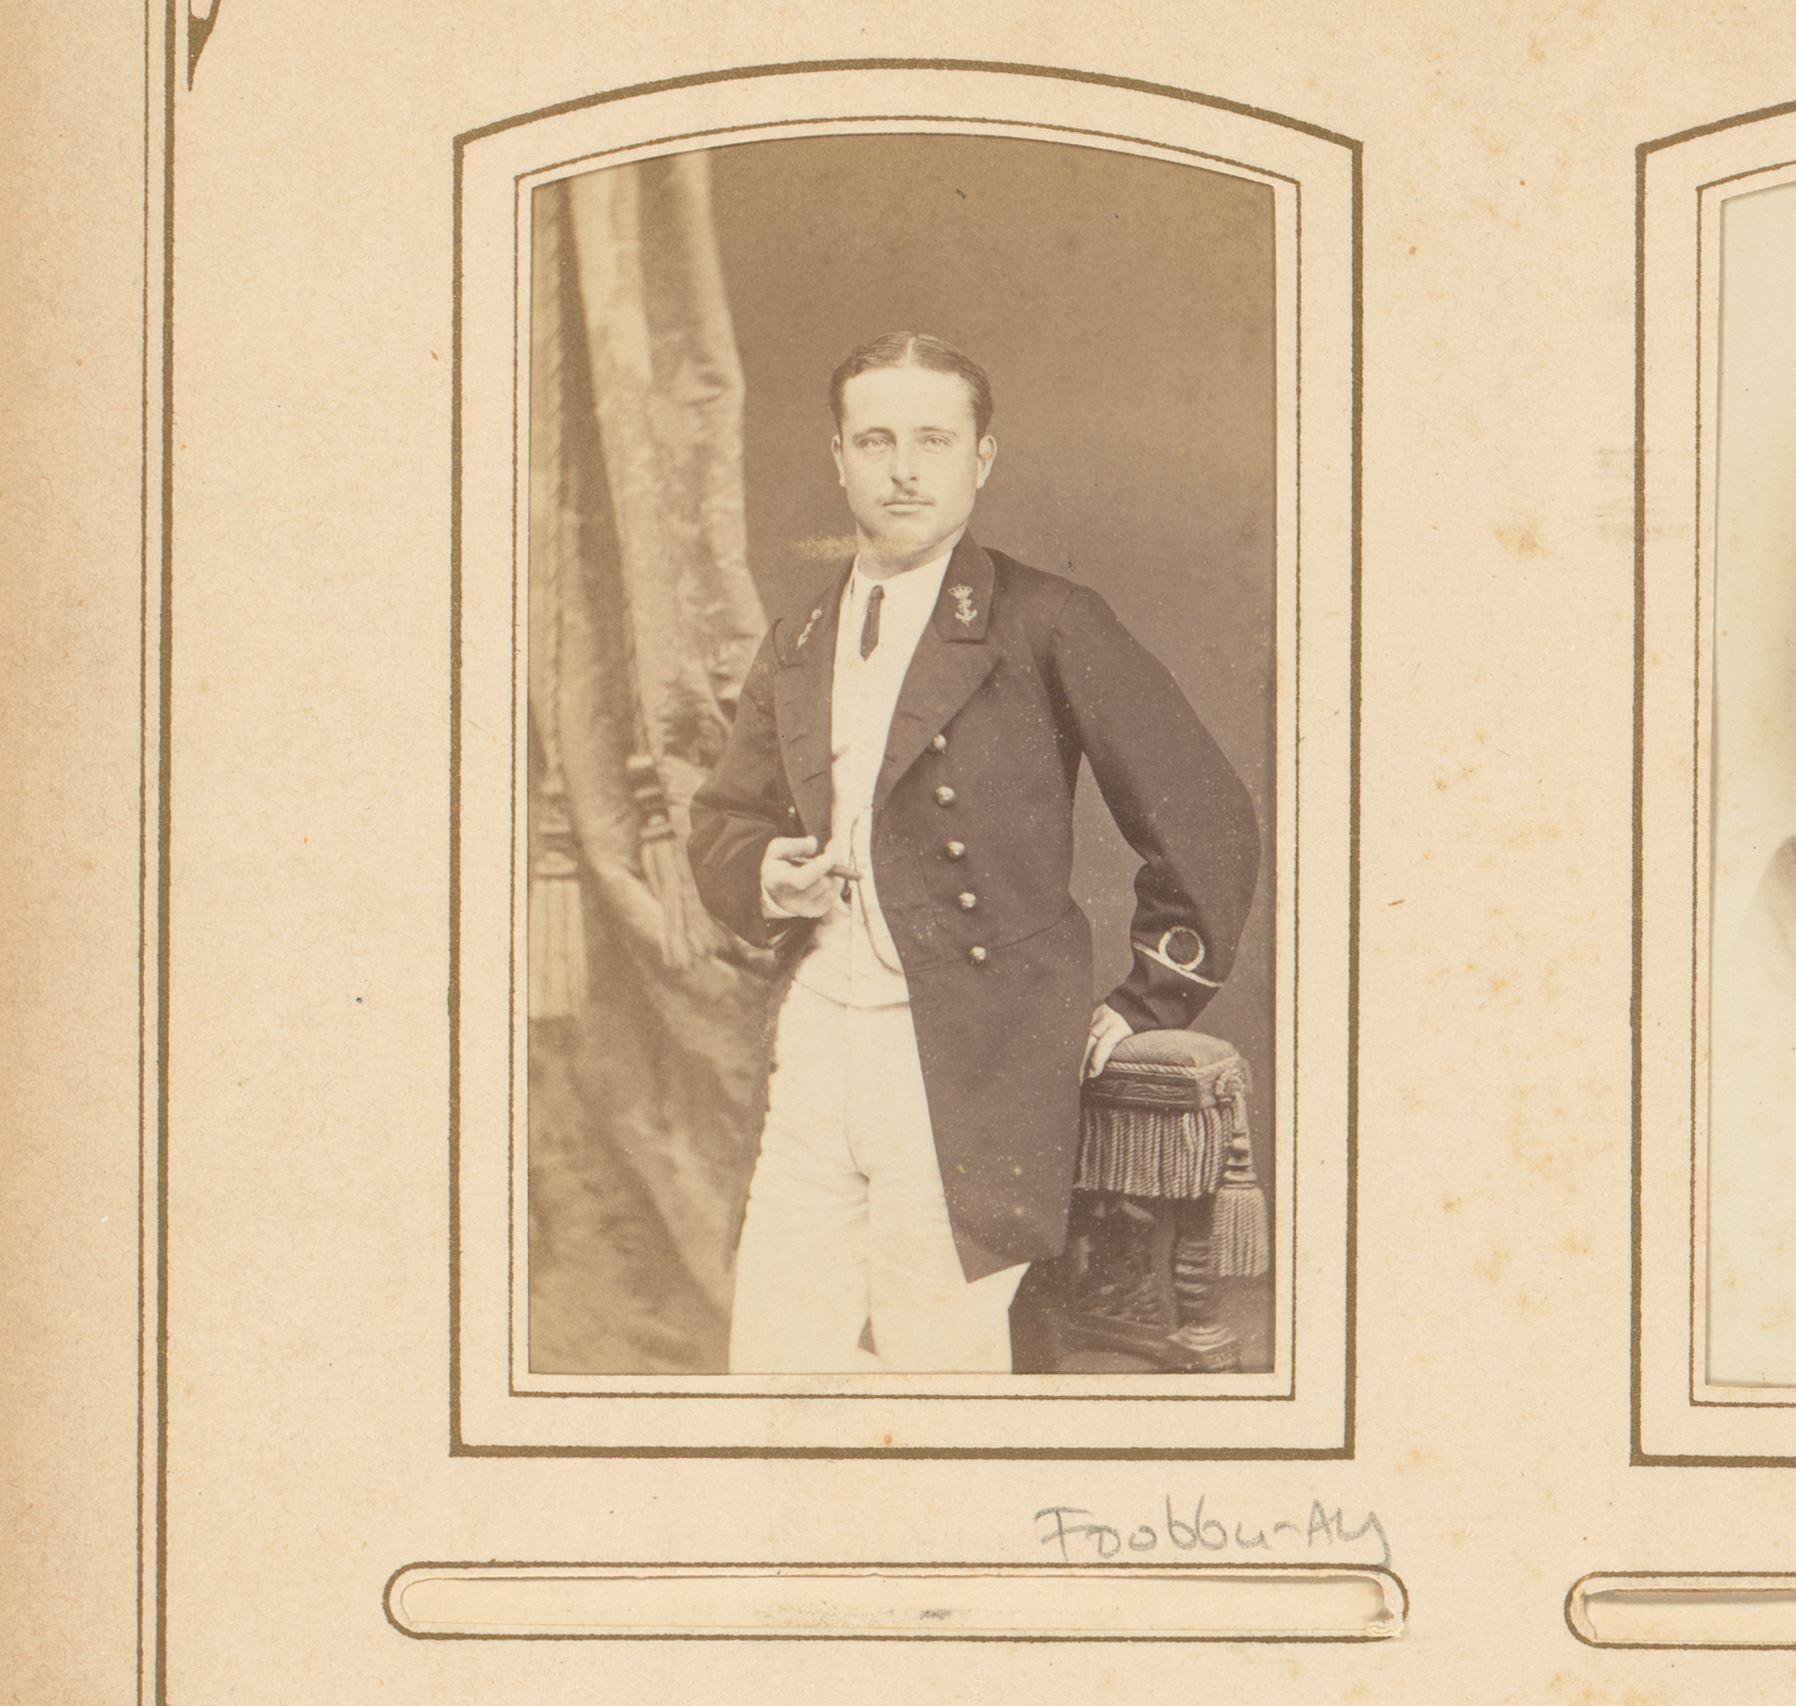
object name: album leaf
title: Portret van een man met insignes op jas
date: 1860-1880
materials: cardboard, photographic support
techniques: albumen print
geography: java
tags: historical persons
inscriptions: inscription: ‘Woodbury & Page/ Photographers/ Java’